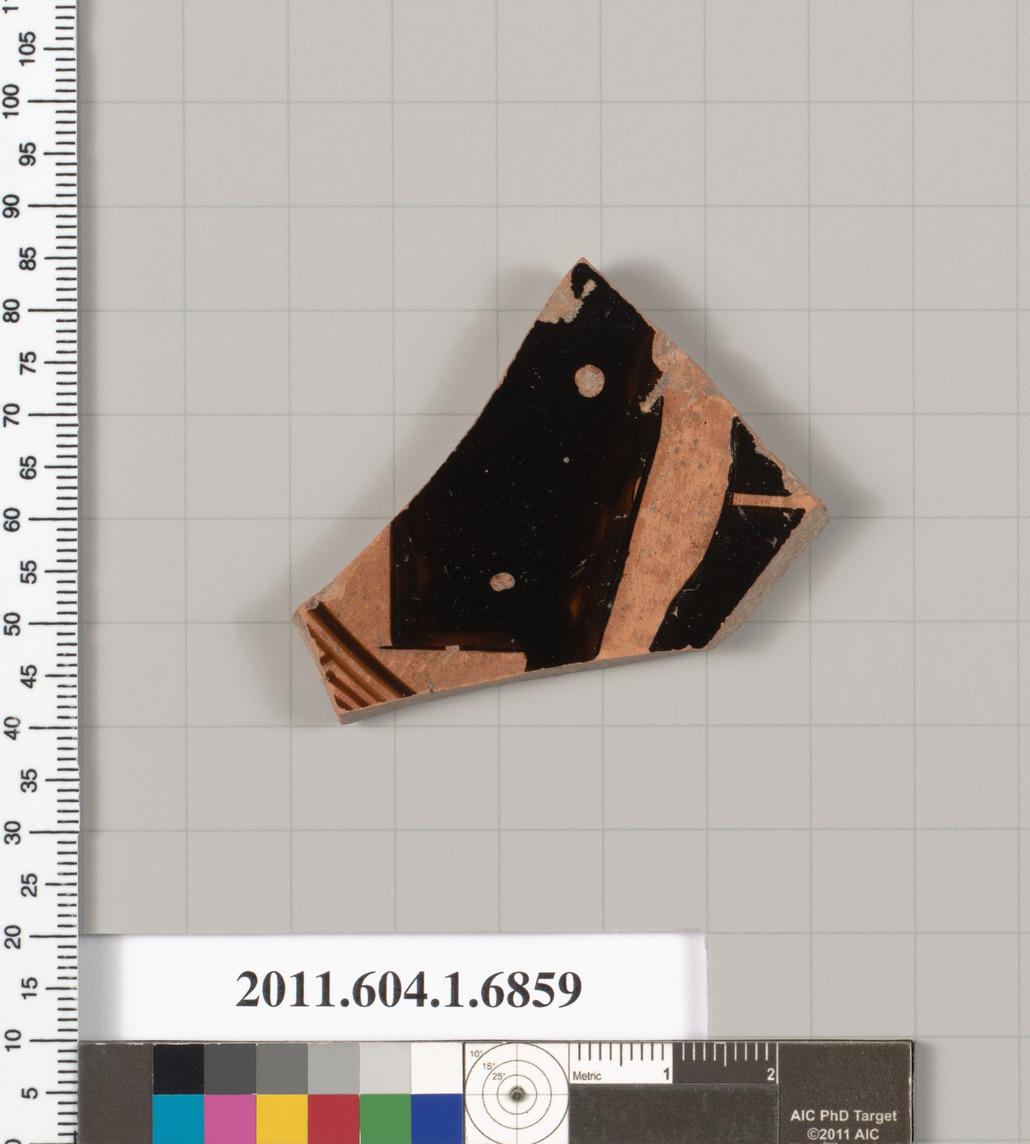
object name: kylix fragment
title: Terracotta fragment of a kylix (drinking cup)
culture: greek, attic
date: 490-470 BCE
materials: terracotta